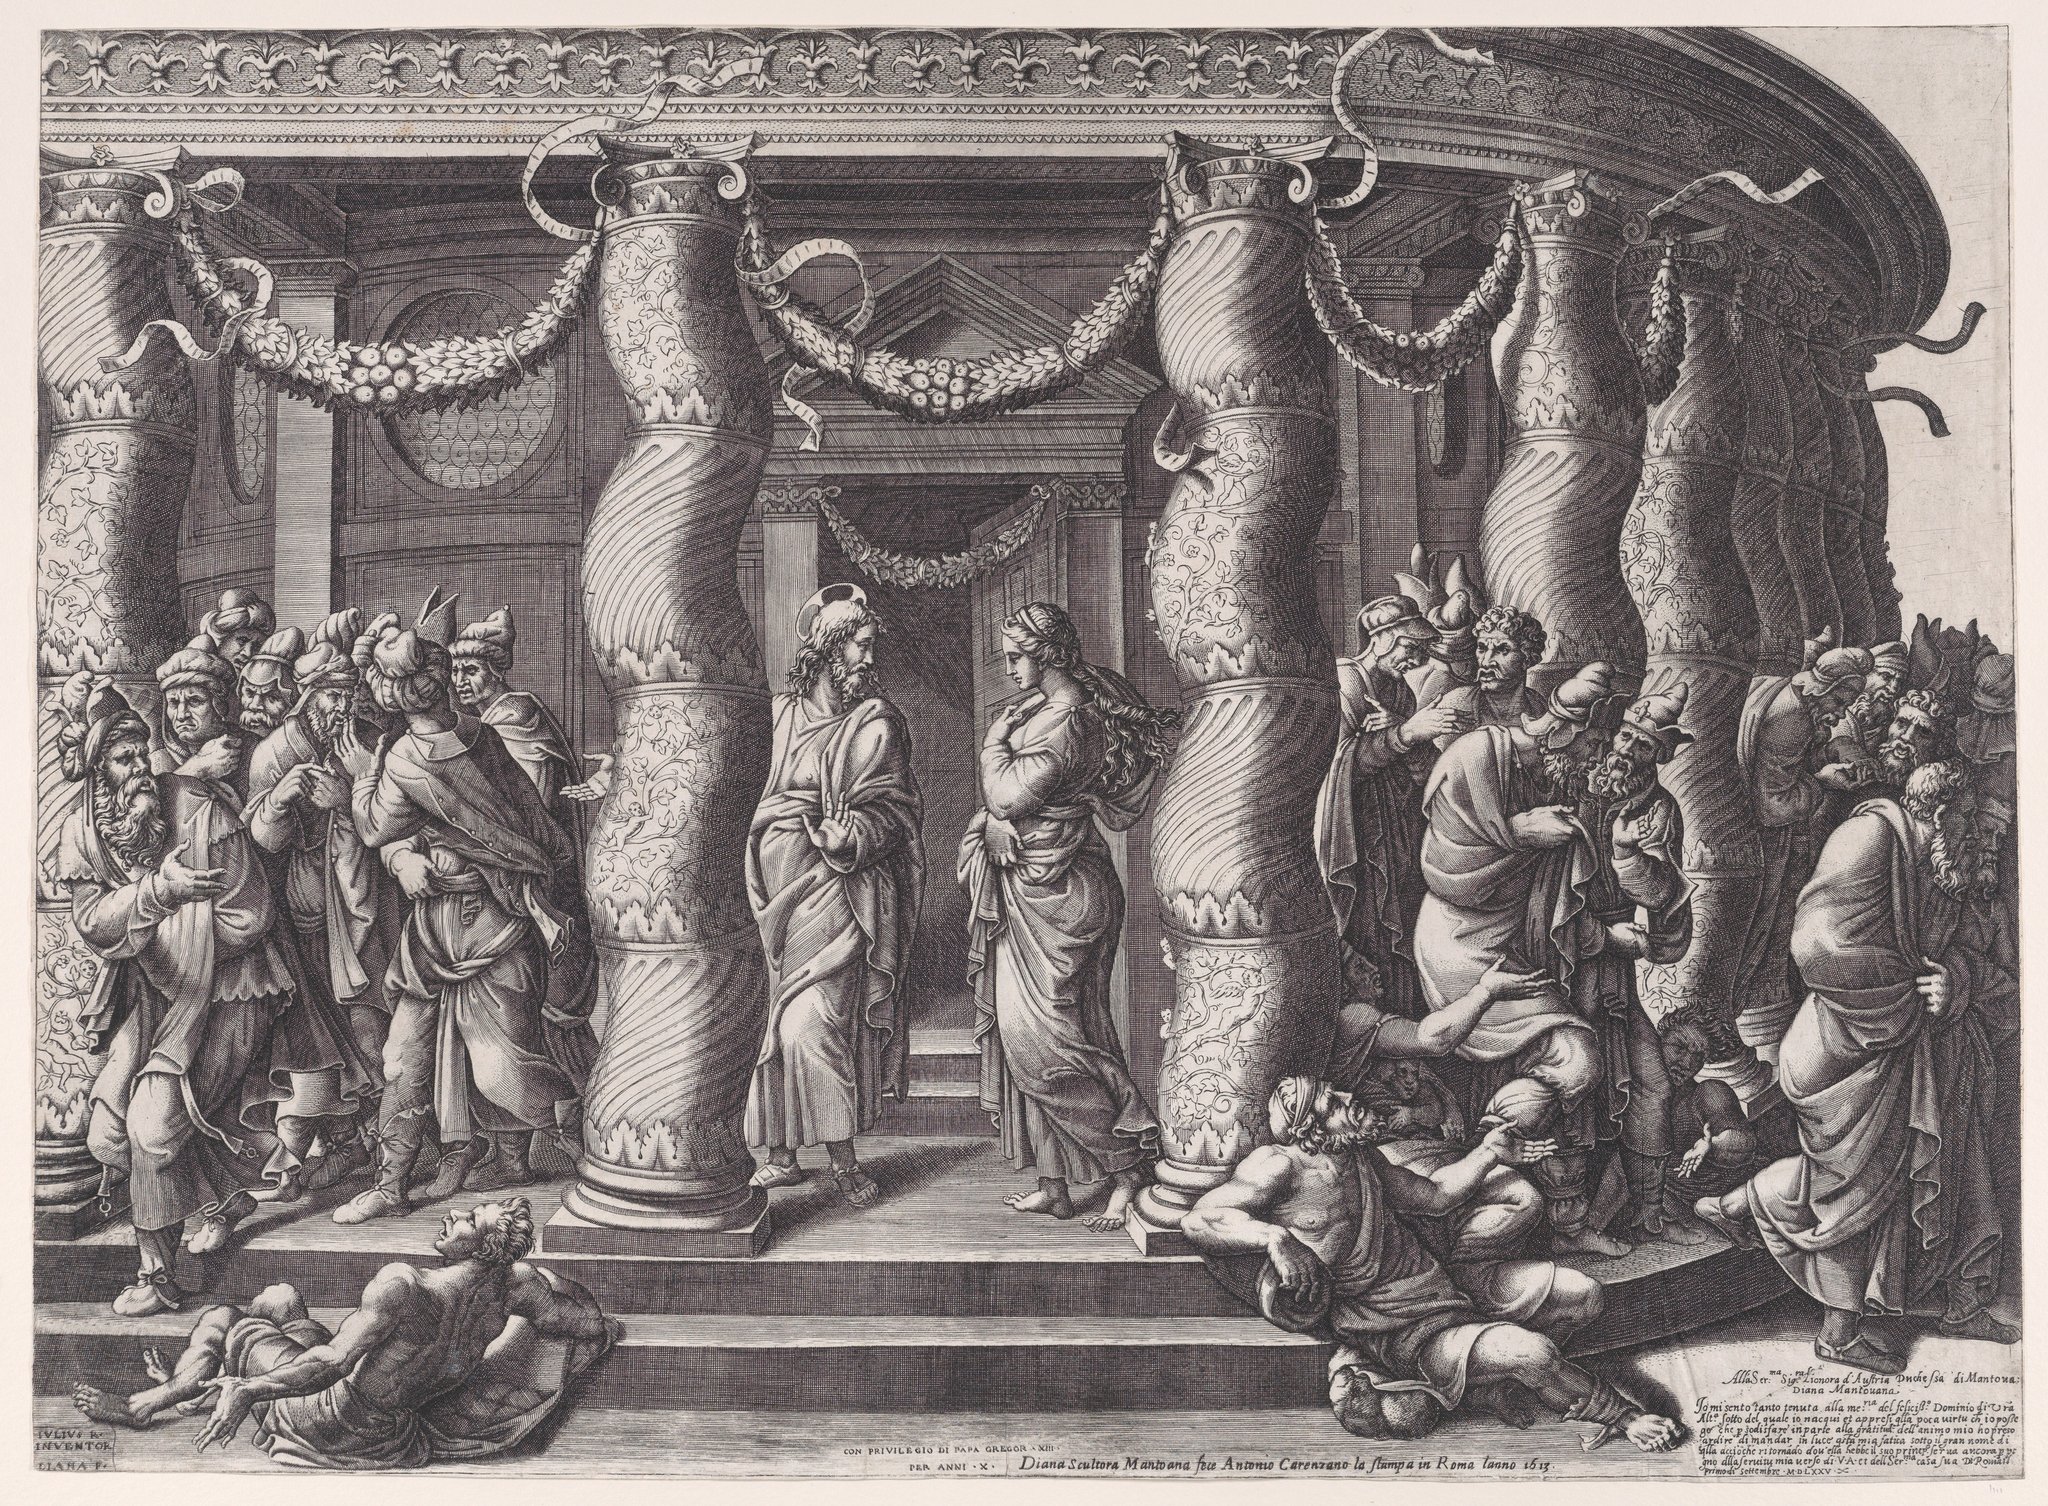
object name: print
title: Christ and the woman taken in adultery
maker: diana scultori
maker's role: artist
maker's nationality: italian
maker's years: 1535-1588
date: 1575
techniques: engraving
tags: columns,men,women,christ